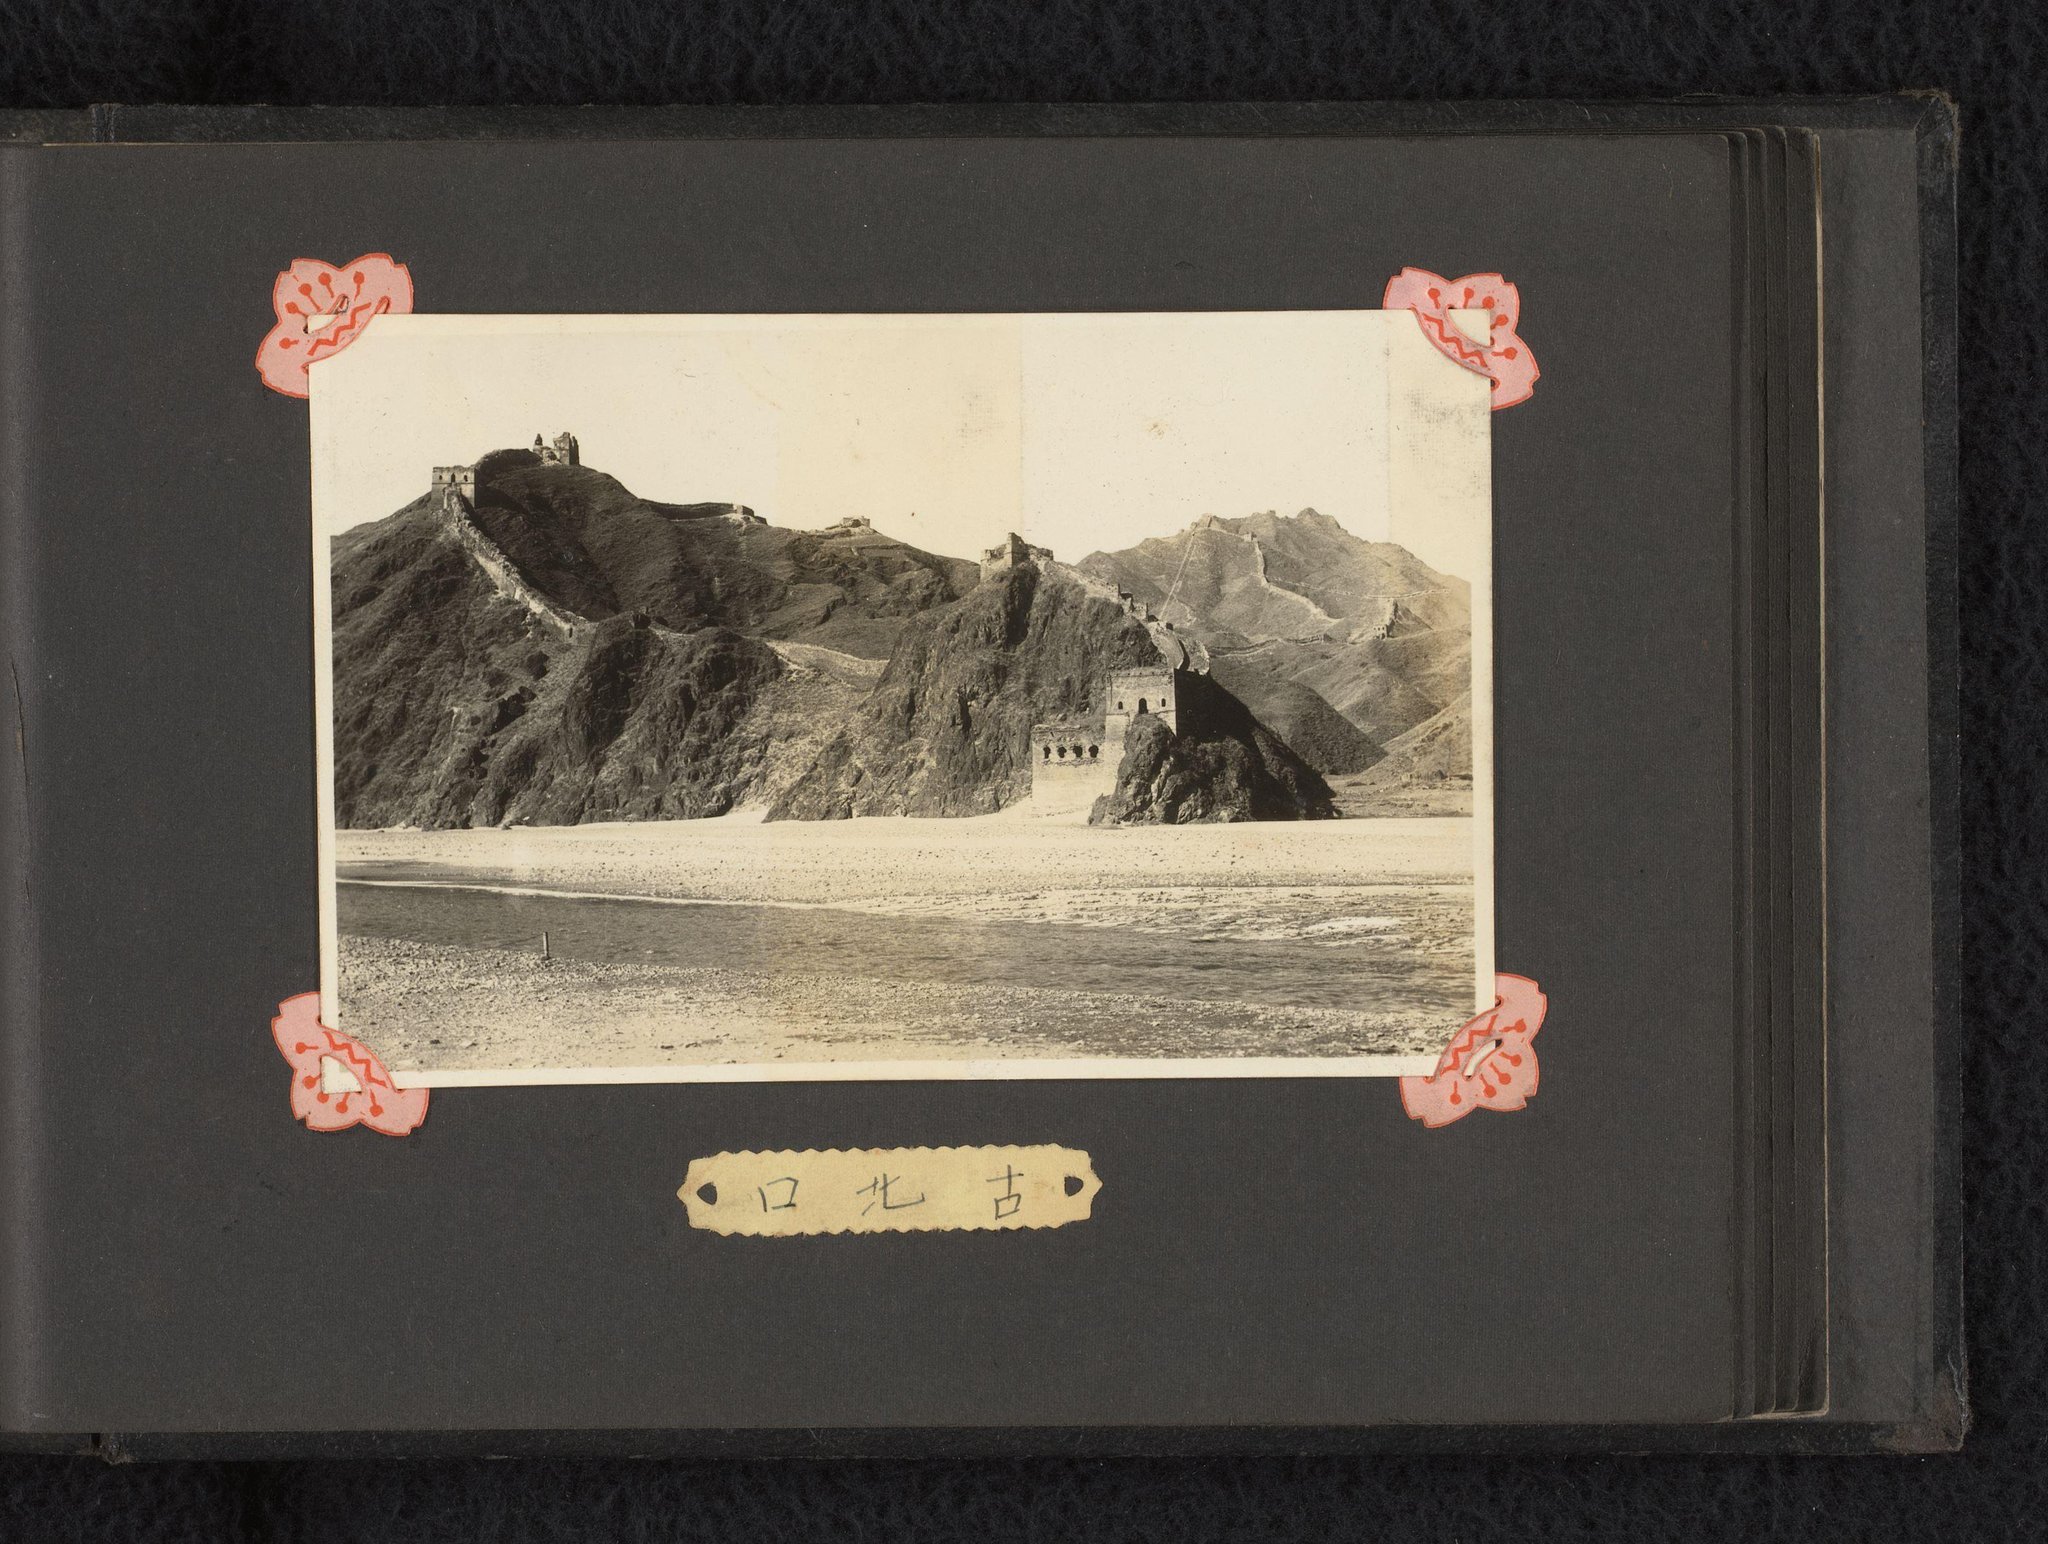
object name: photograph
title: Gezicht op het oostelijk eindpunt van de Chinese Muur in Shanhaiguan, China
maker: Anonymous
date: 1937-1941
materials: paper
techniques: gelatin silver print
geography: shanhaiguan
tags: fortifications, military engineering, walls ~ fortified city